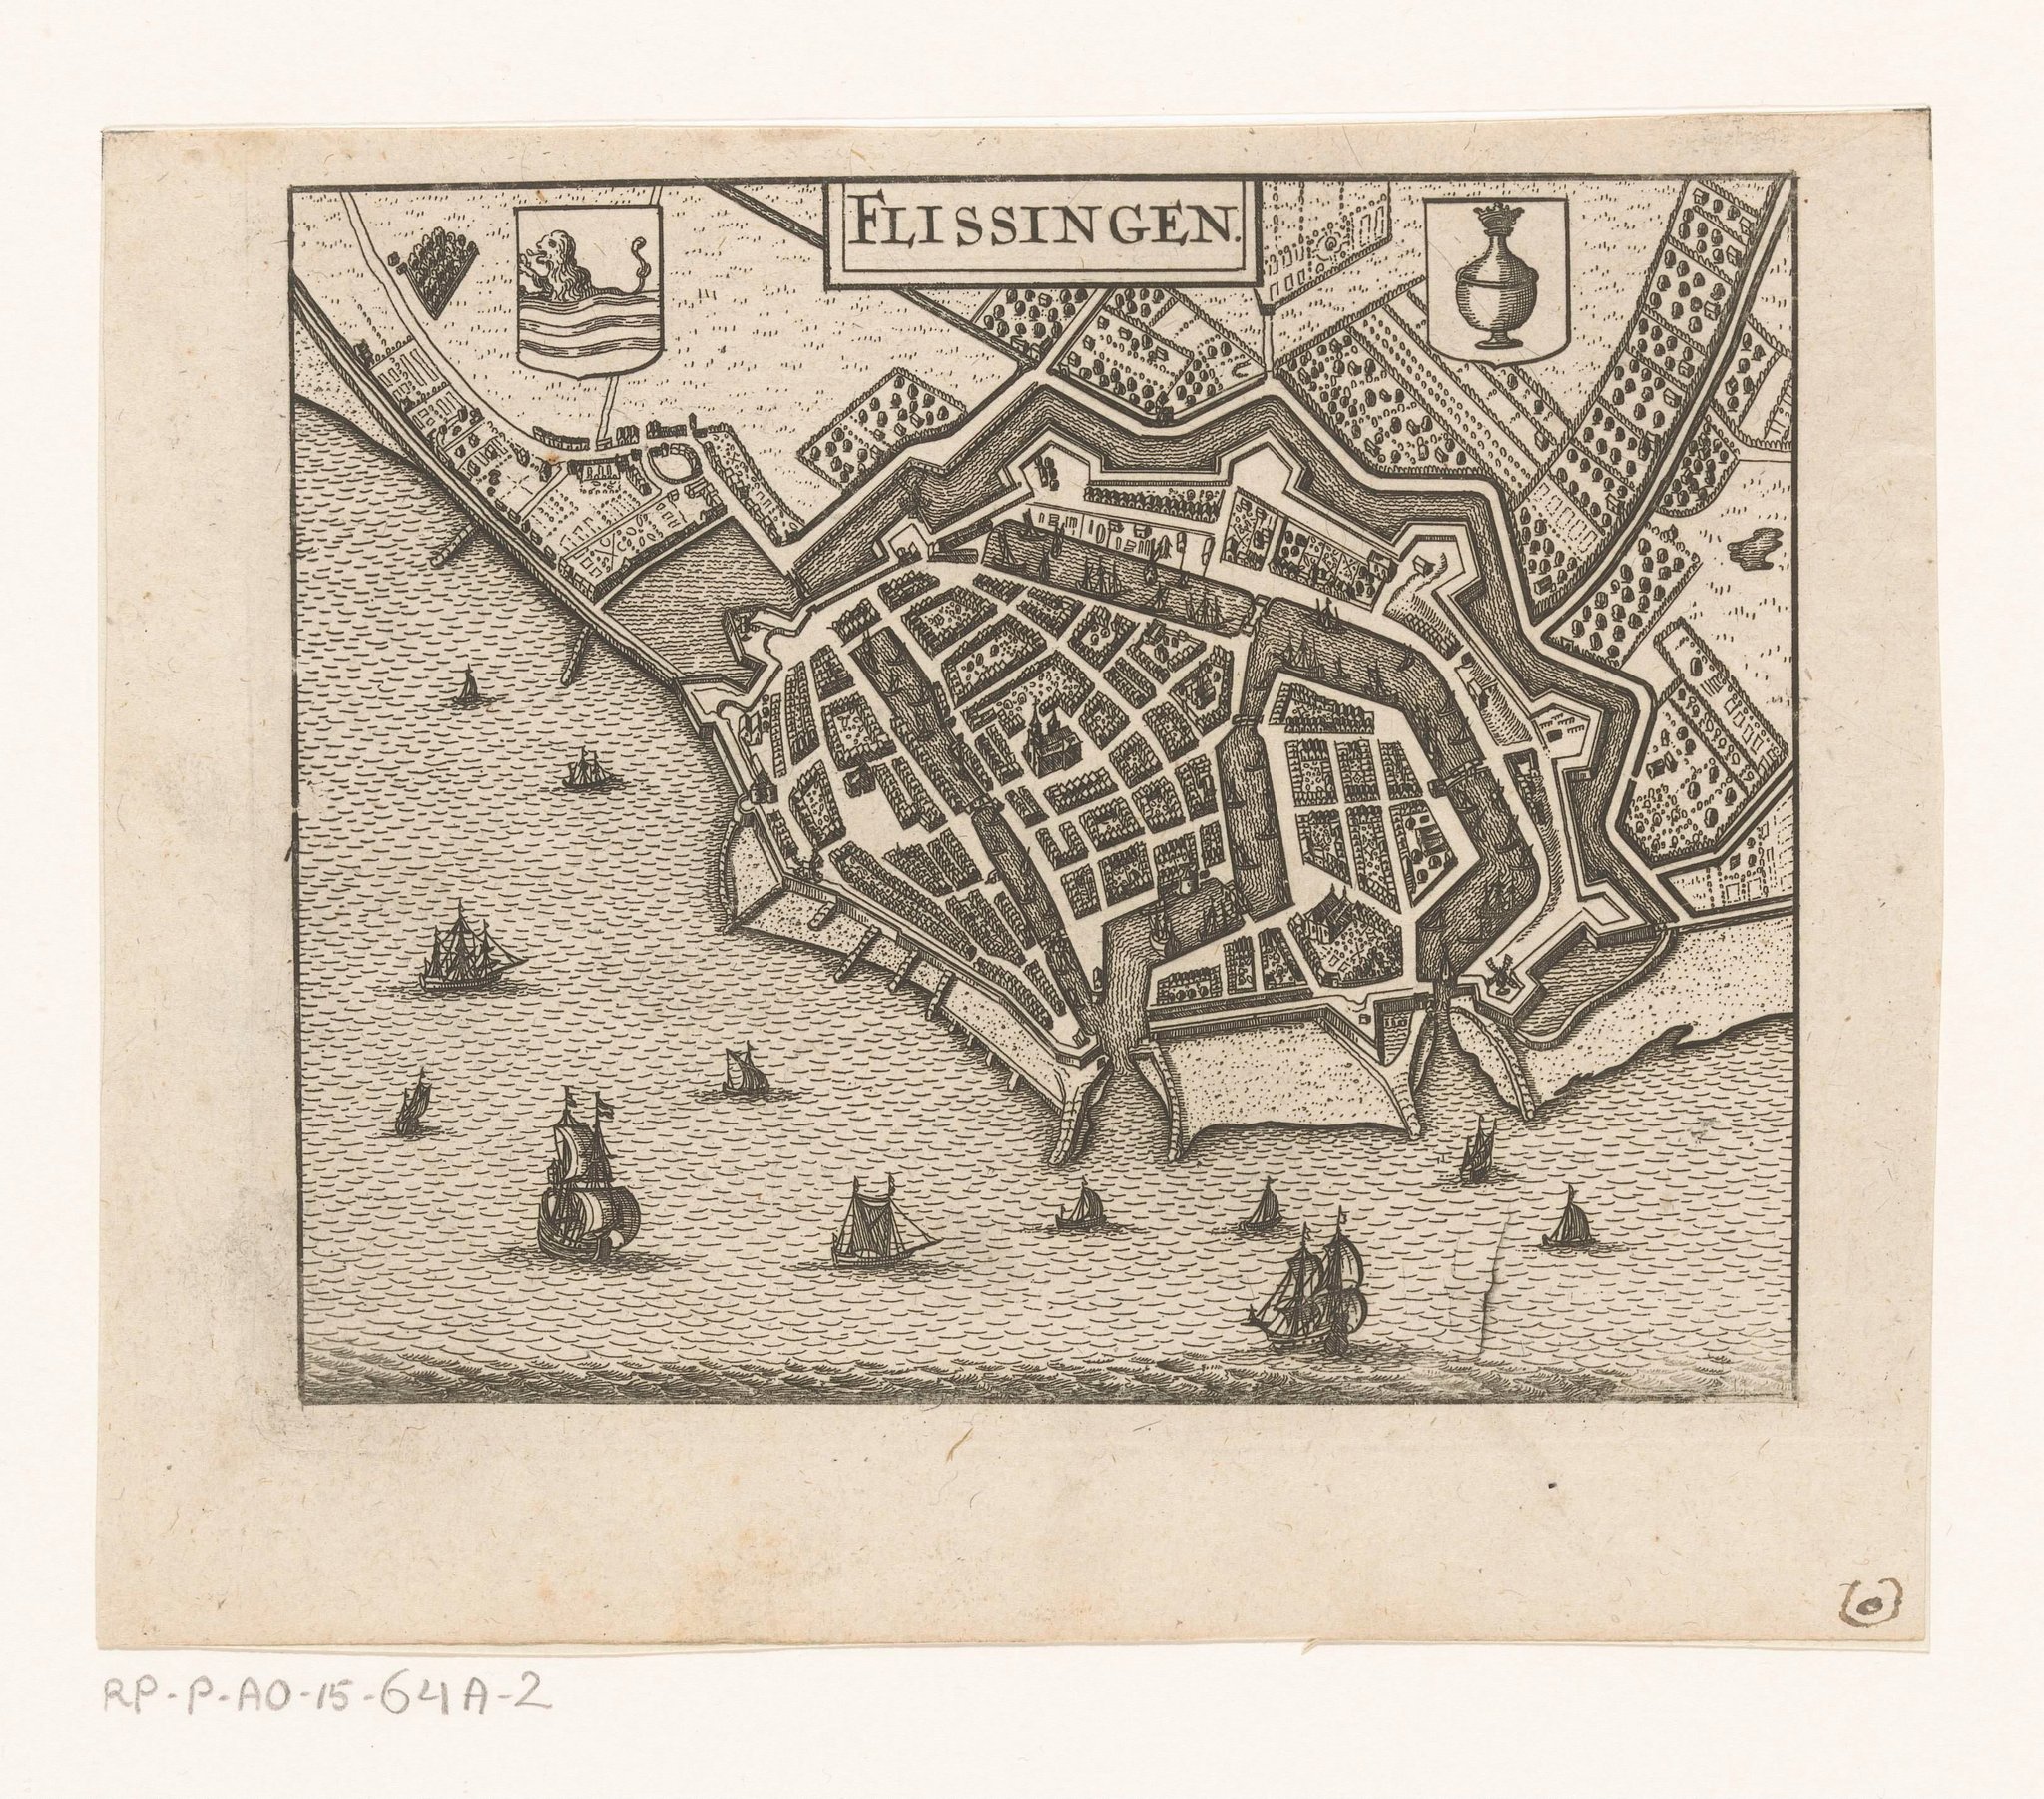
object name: area plan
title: Plattegrond van Vlissingen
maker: Anonymous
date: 1652-1662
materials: paper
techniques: etching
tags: coat of arms (as symbol of the state, etc.) (+ city; municipal), maps of cities, coat of arms (as symbol of the state, etc.) (+ province; provincial), flushing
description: Prent ook gebruikt in: Guicciardini, Lodovico. Belgicae, sive inferioris Germaniae descriptio. 3 delen. Amsterdam: Johannes Janssonius, 1652. En in: Caert en stede-boexken van Nederlandt, vertoonende de XVII. Provintien (…). Amsterdam: Jan Janssen Brouwer, 1652. En in: Guicciardini, Lodovico. Belgicae, sive inferioris Germaniae descriptio Amsterdam: Jacob van Meurs, 1660. En in: Guicciardini, Lodovico. Beschryvingh der Neder-landen (…). 2 delen. Amsterdam: Jacob van Meurs, 1660. En in: Guicciardini, Lodovico. Beschryvingh der Neder-landen (…). 2 delen. Amsterdam: Jacob van Meurs, 1662. Uit welke uitgave het huidige exemplaar precies komt is niet na te gaan.